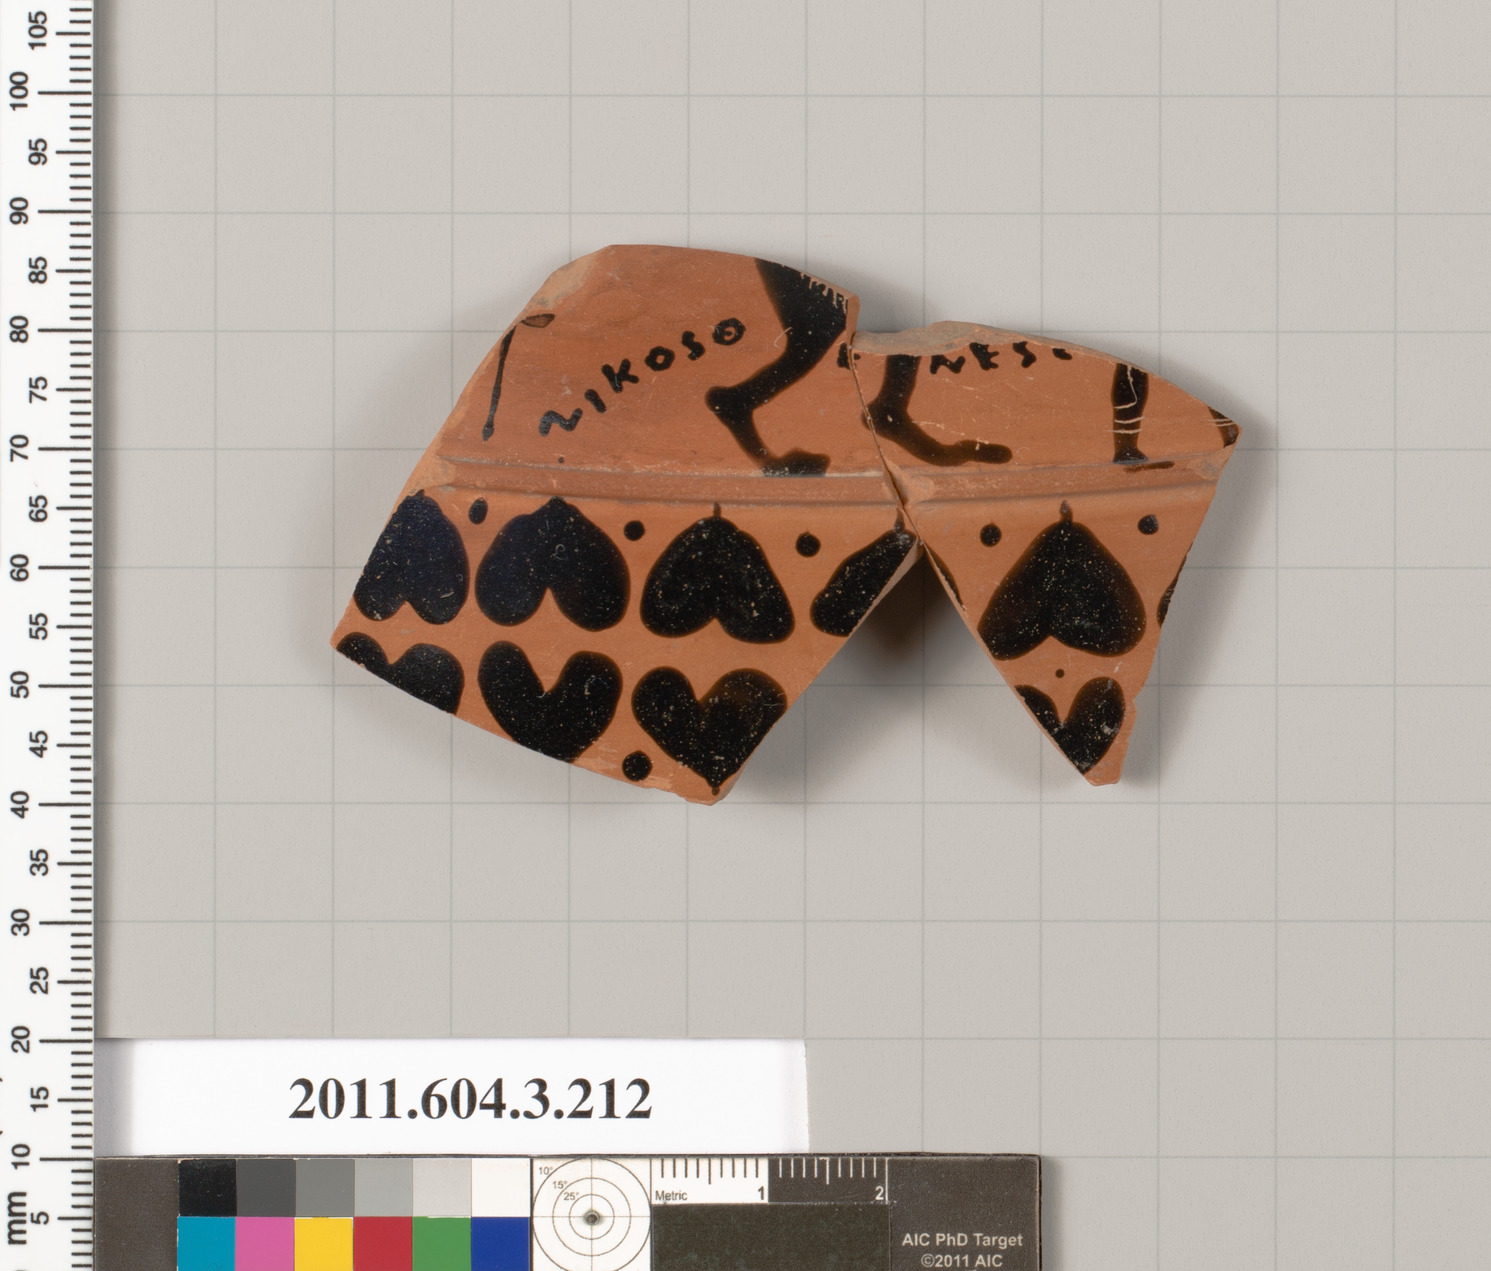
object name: neck amphora fragment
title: Terracotta fragment of a neck-amphora of Nicosthenic shape (jar)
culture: greek, attic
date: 525-501 BCE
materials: terracotta